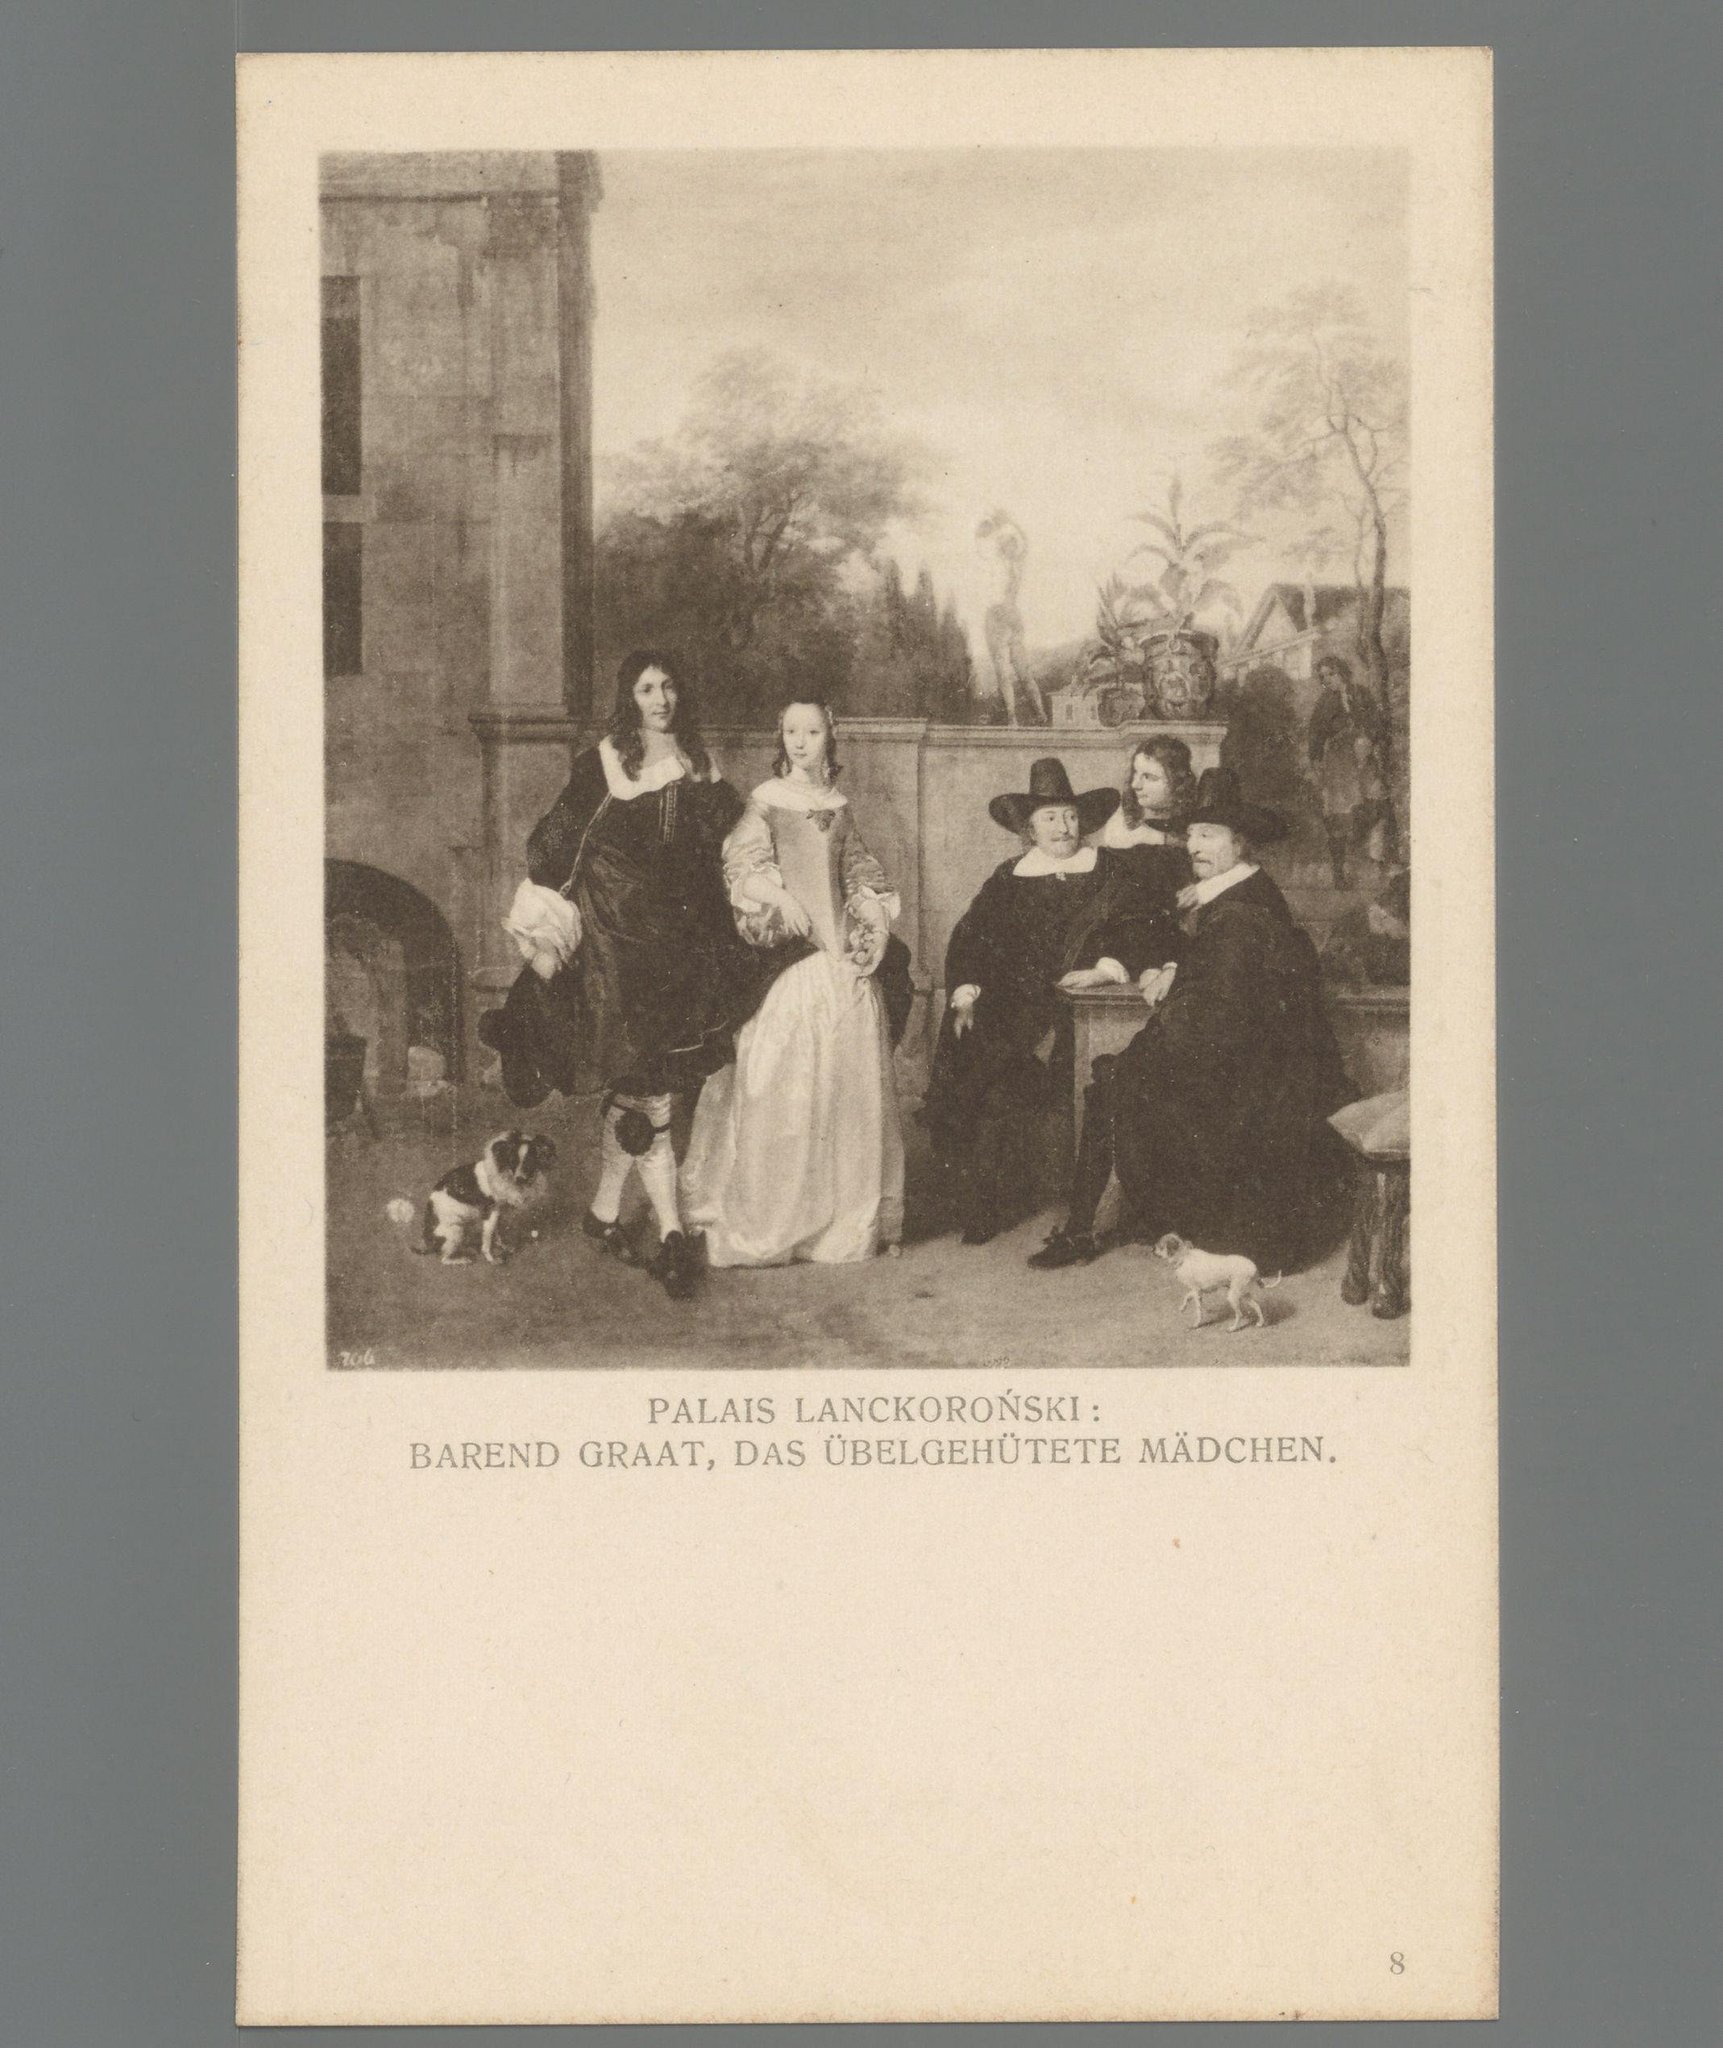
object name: reproduction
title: Palais Lanckoronski: Barend Graat, Das übelgehütete Mädchen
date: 1912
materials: cardboard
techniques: photograph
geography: vienna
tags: adult woman (+ four persons), garden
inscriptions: date